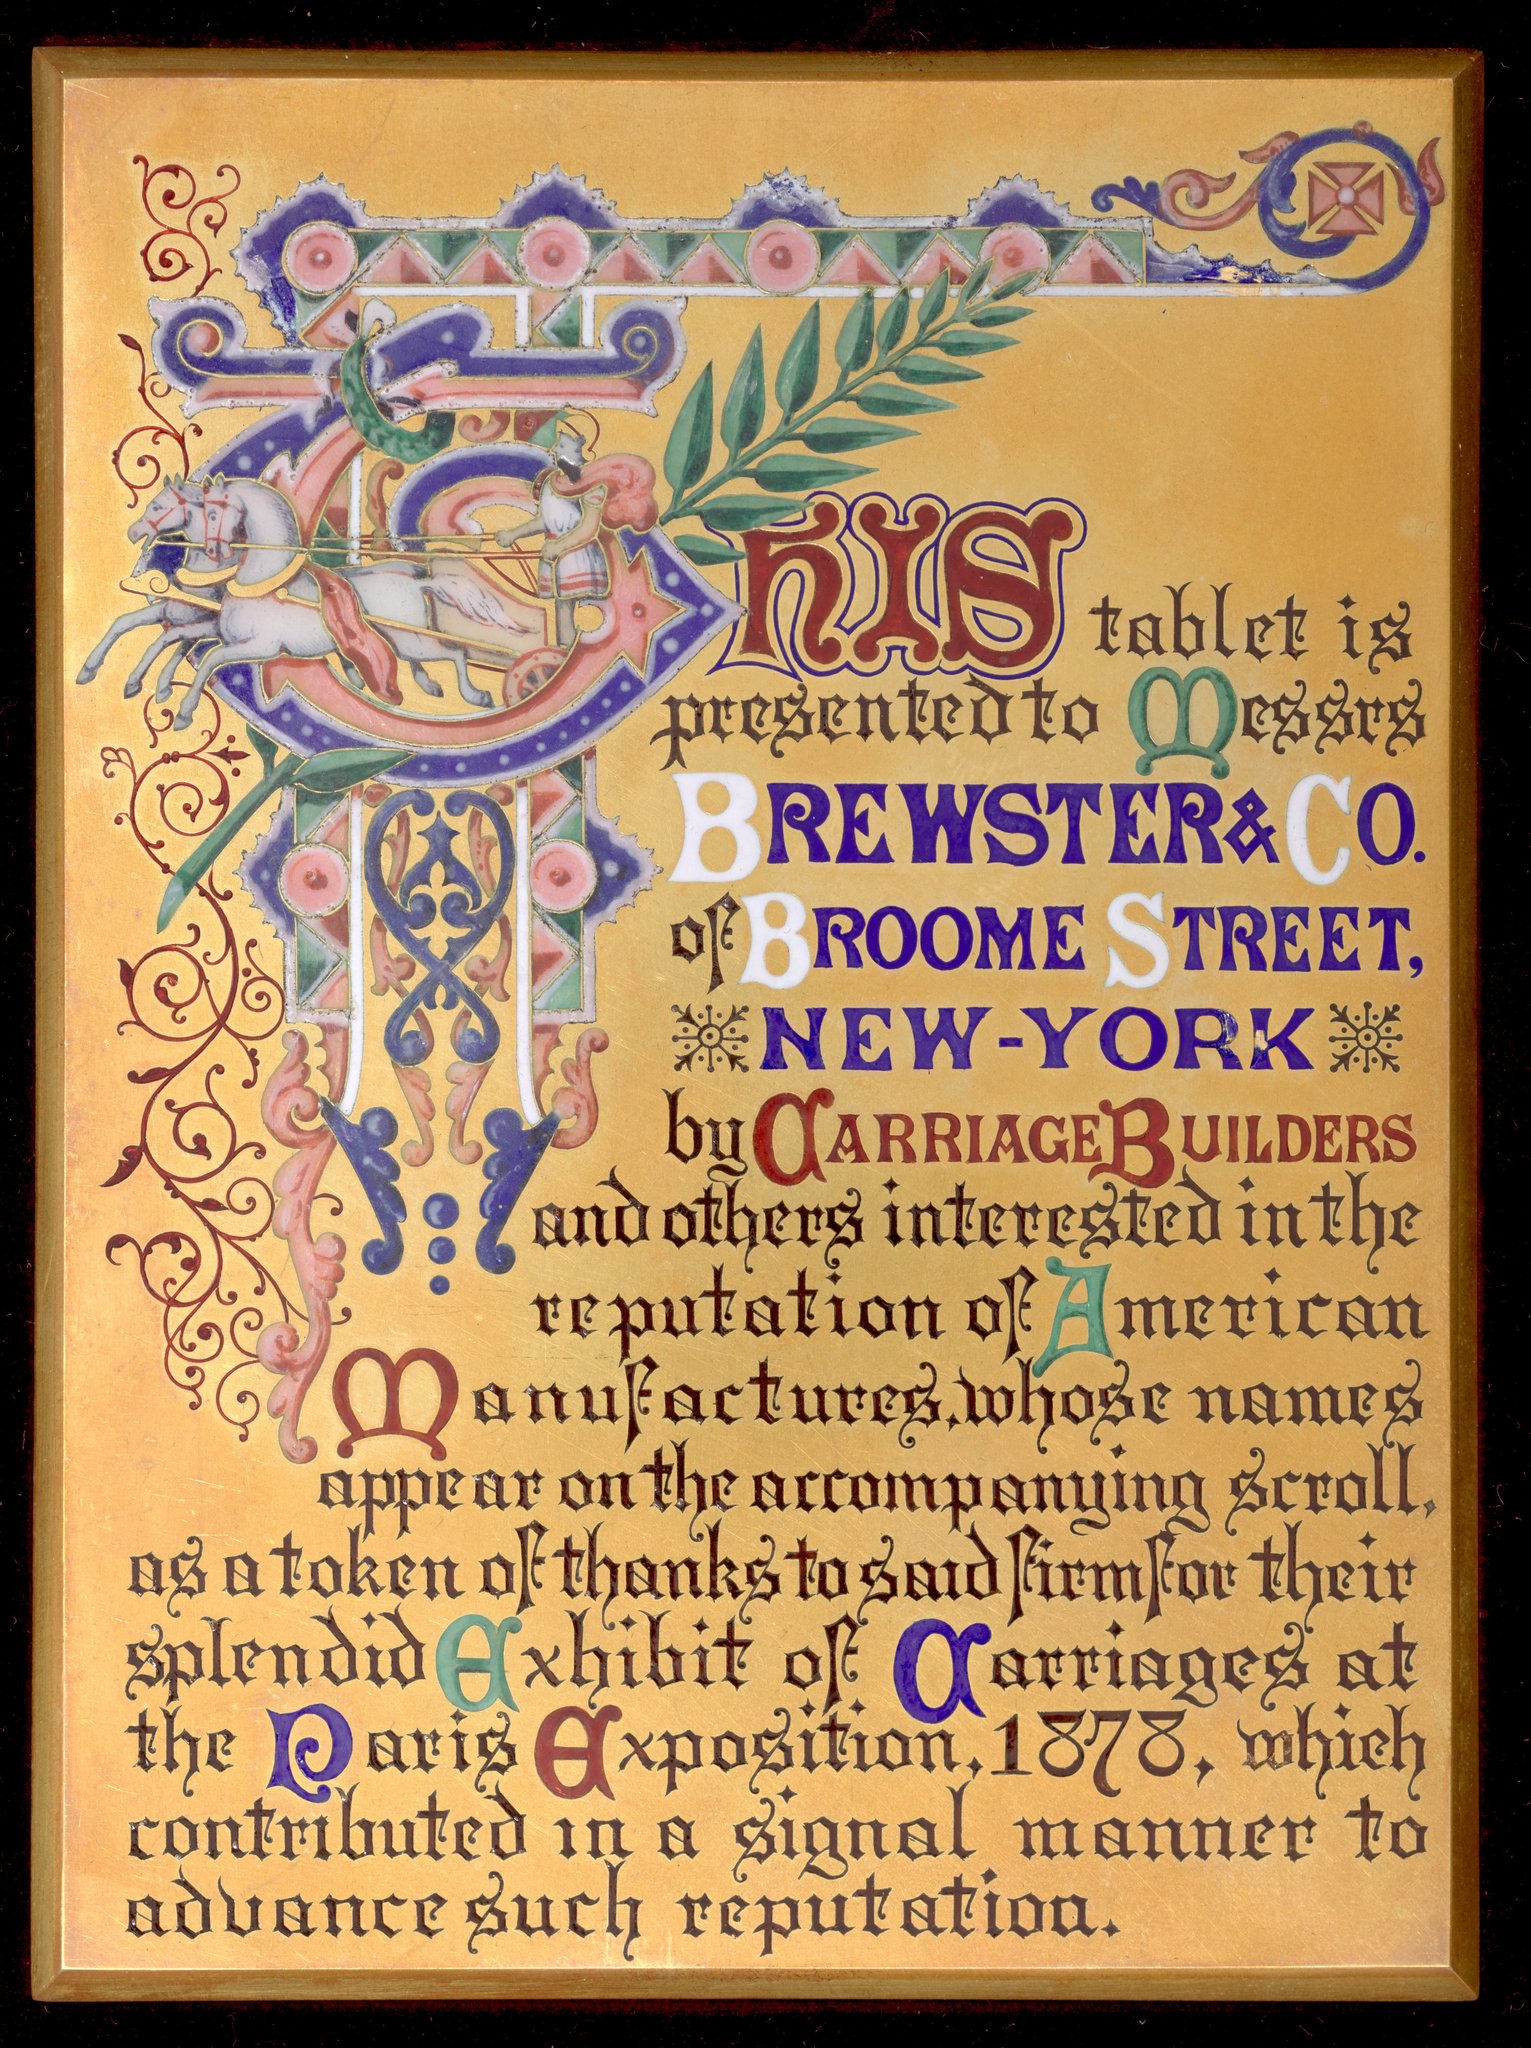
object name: plaquette enamel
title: Tablet presented to Brewster & Co. of Broome Street, in recognition of their carriage exhibition at the Paris Fait of 1878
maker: tiffany & co.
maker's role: artist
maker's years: 1837-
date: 1878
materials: enamel, gilt bronze